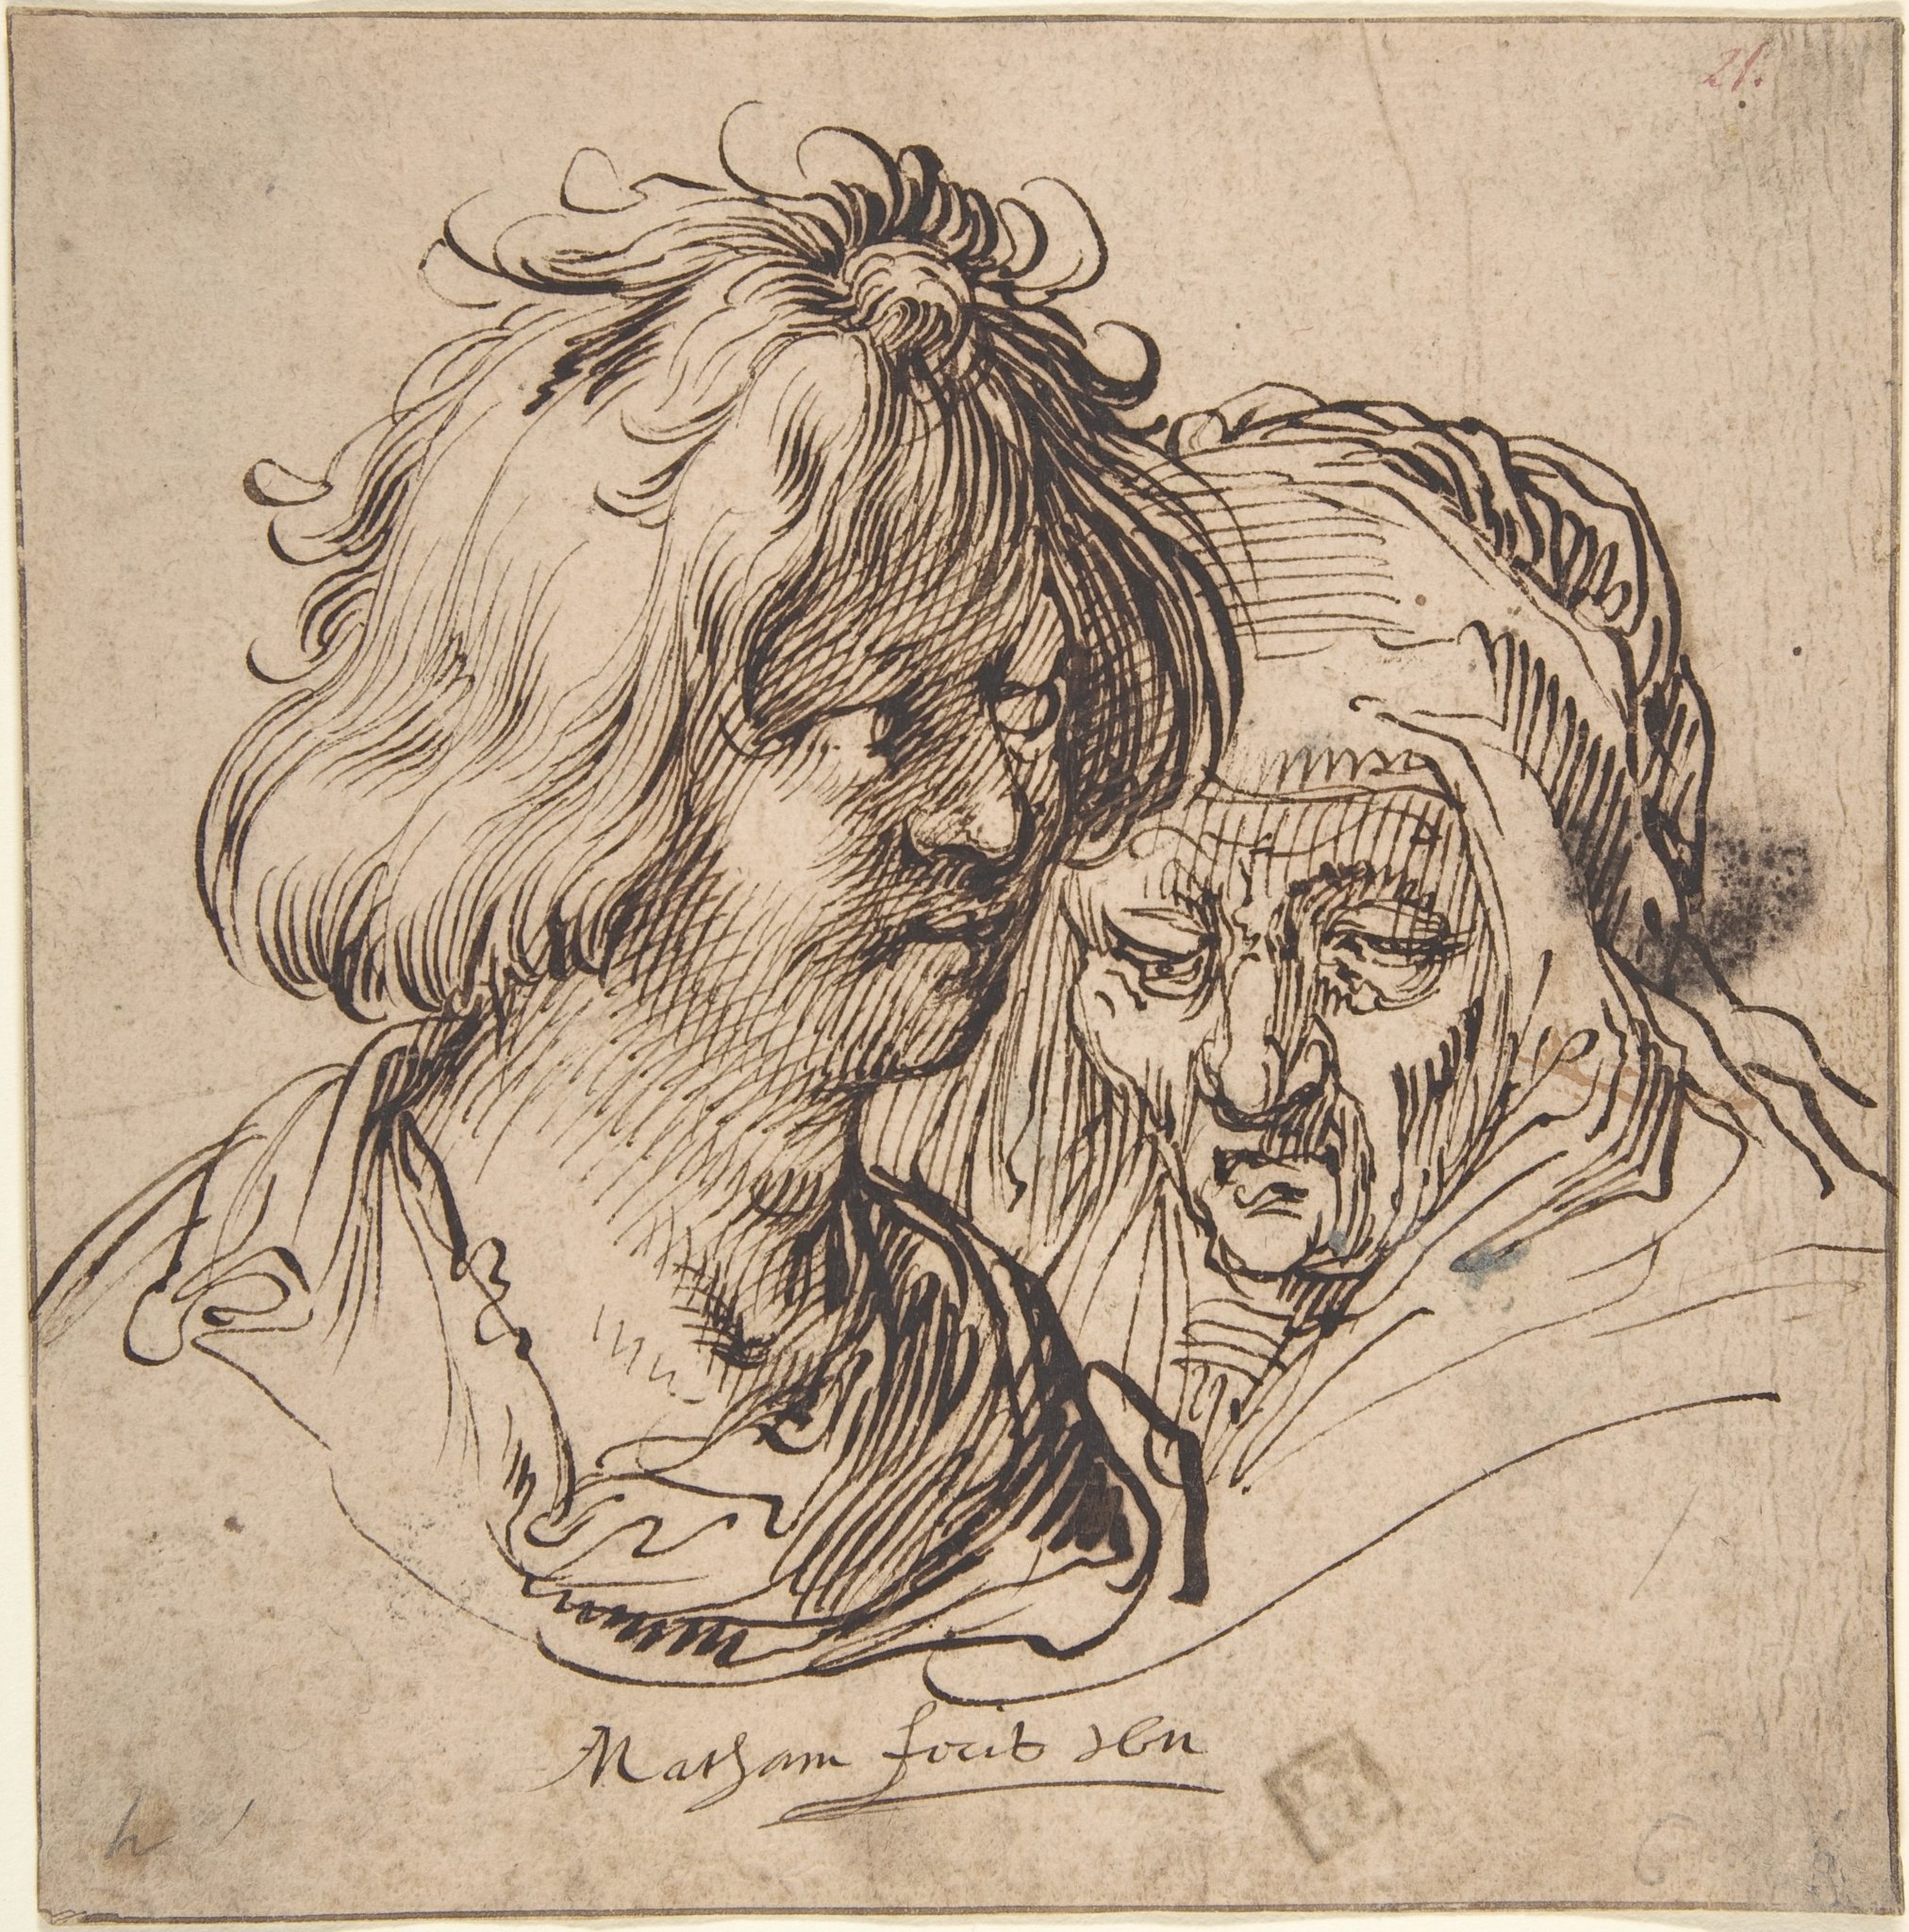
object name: drawing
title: Young Man and Old Woman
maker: jacob matham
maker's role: artist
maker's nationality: netherlandish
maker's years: 1571-1631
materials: ink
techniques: pen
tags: men,women